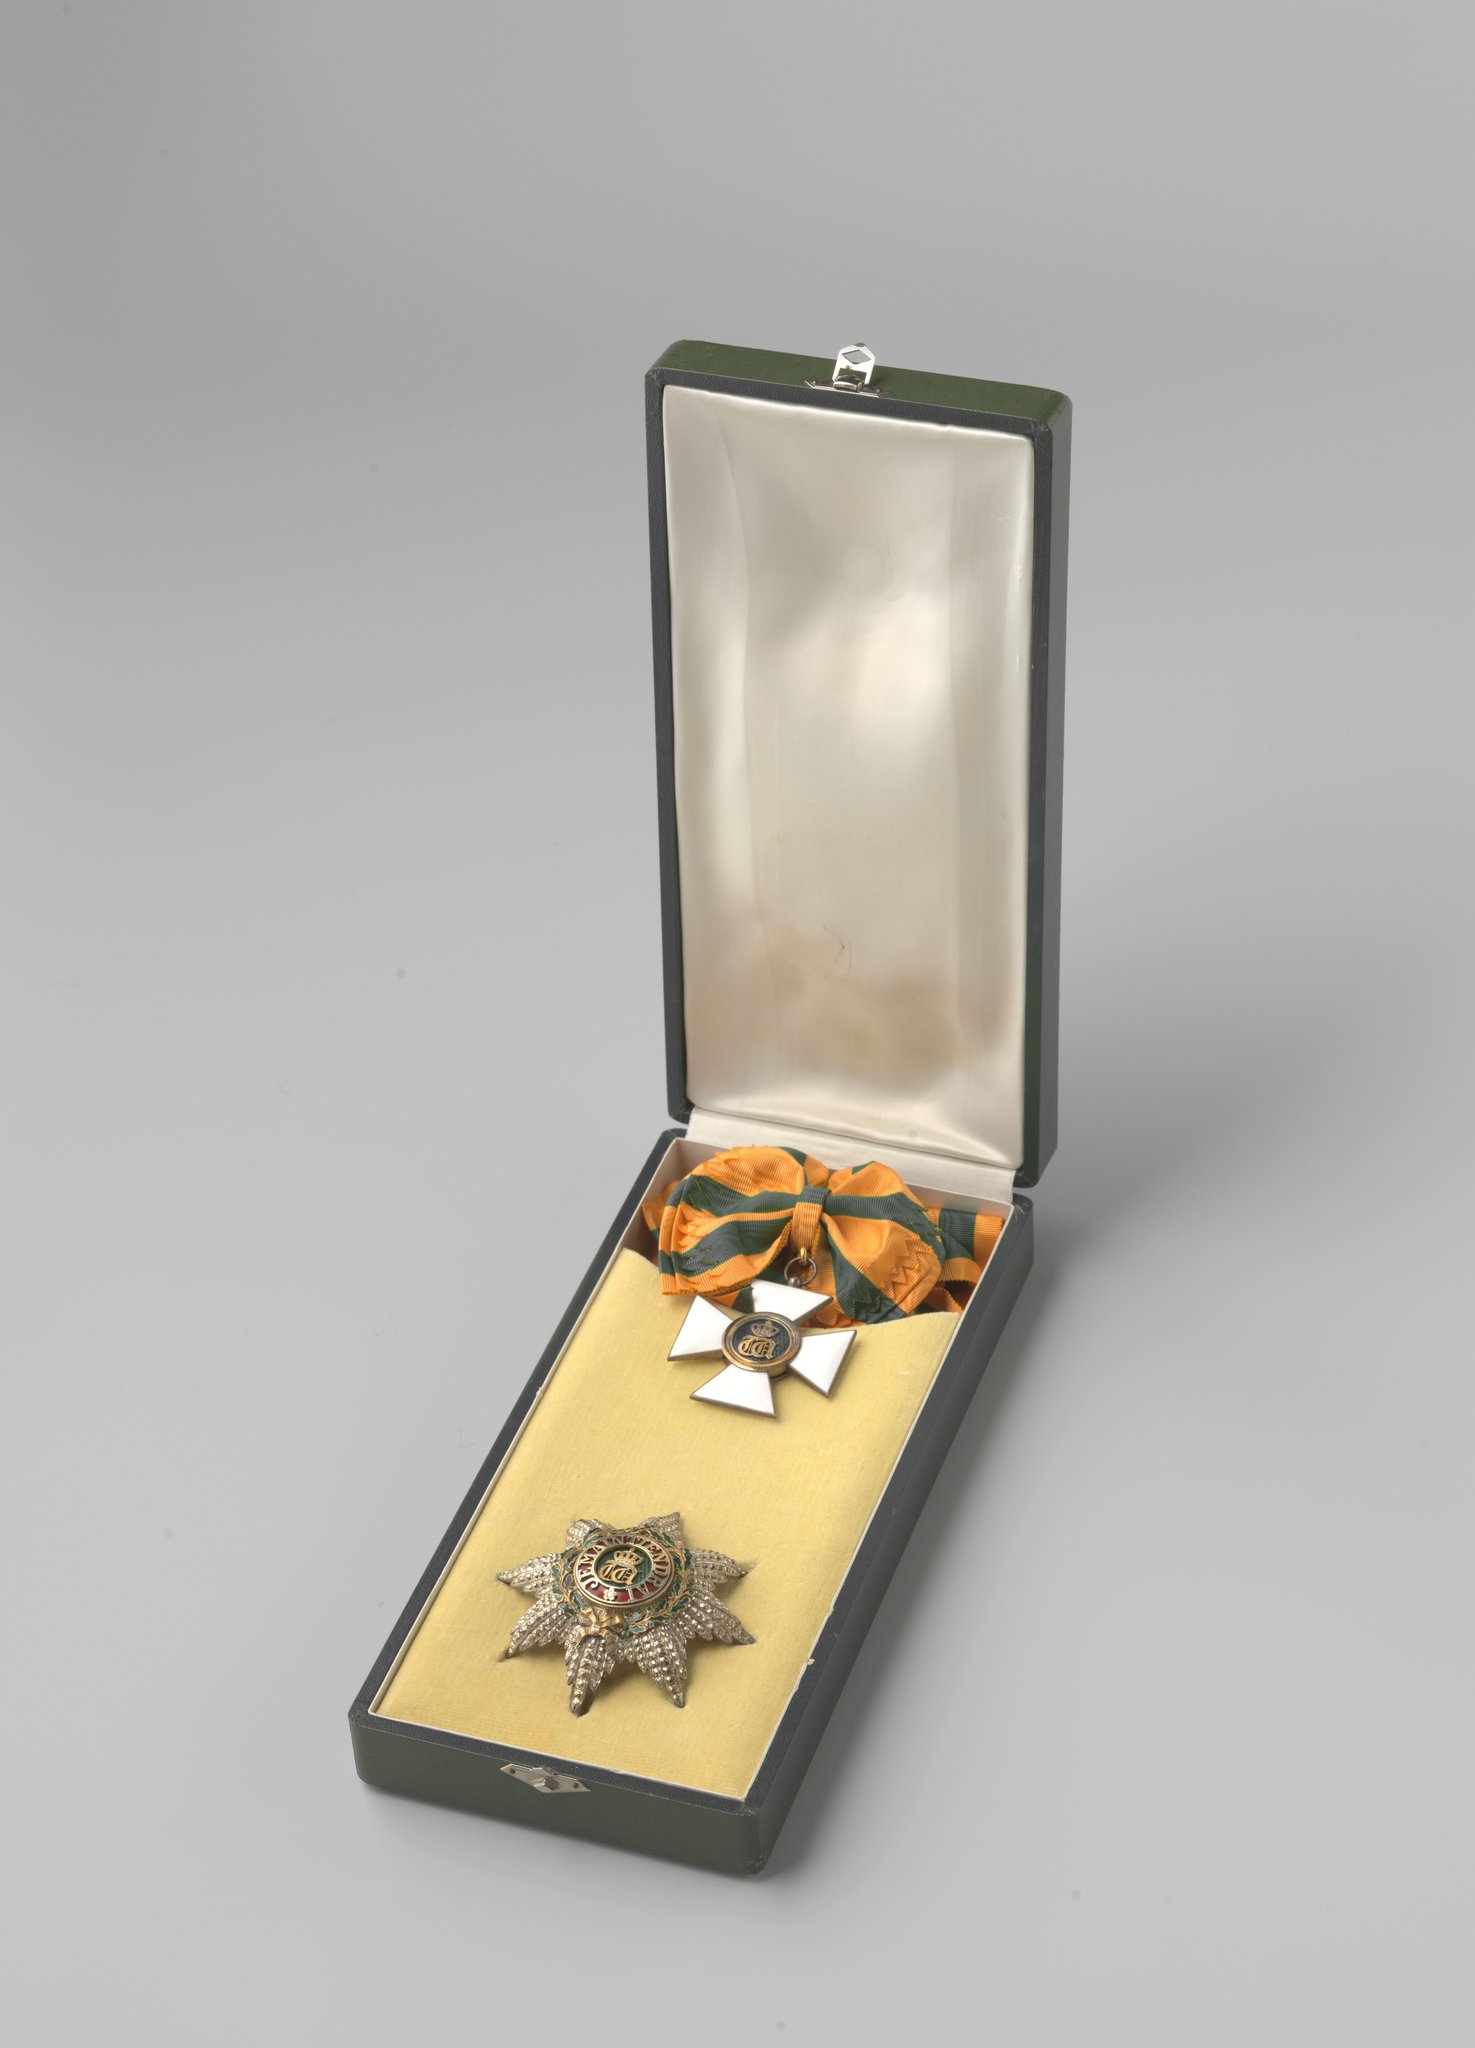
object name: blotter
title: Luxemburgse ridderorde (Orde van de Eikenkroon), ontvangen door Willem Drees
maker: Anonymous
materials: silver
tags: amsterdam, the hague, willem drees, netherlands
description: De ordester, die op de kleding wordt gedragen, is een achtpuntige, naar binnen licht gebogen gebrillianteerde zilveren ster met in het midden het medaillon met het initiaal van Willem II, dat hier omkranst wordt met het omschrift 'Je Maintiendrai' in gouden letters op een rode achtergrond. Dit wordt op de stralen van de ster omgeven door een groen-gouden eikenkrans die aan de onderzijde in een strik eindigt.